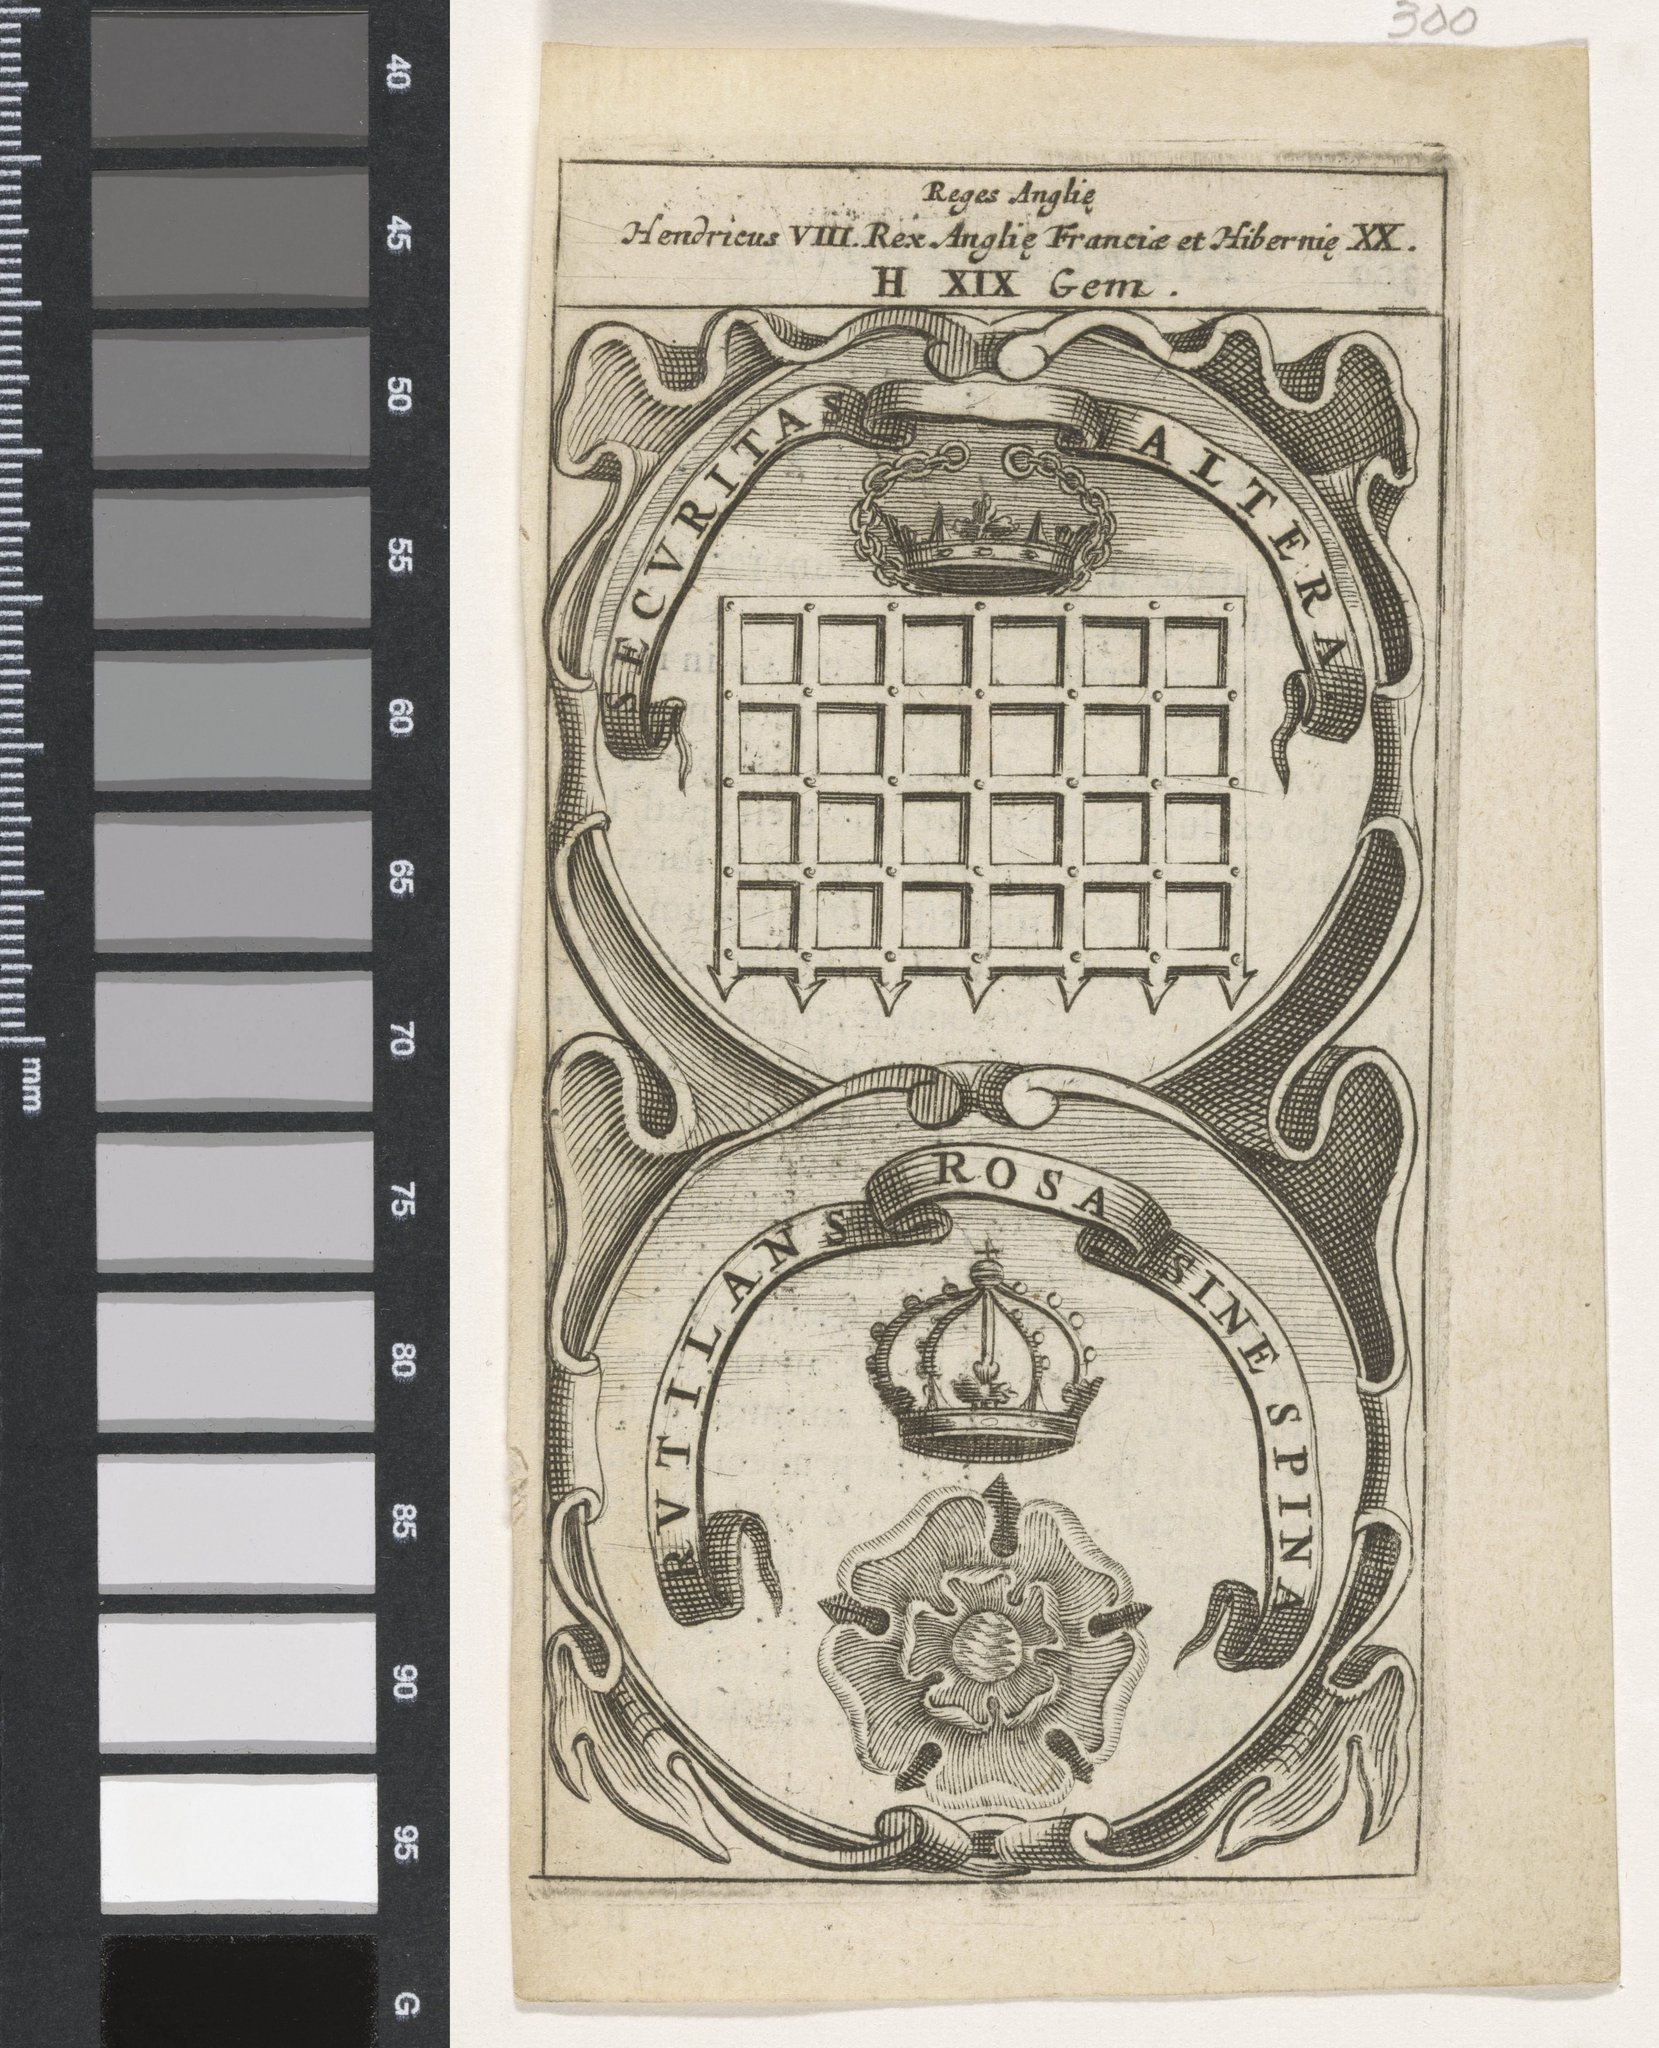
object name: print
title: Symbola Divina et Humana Pontificum Imperatorum Regum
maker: Anonymous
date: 1666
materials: paper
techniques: engraving, letterpress printing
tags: crown (symbol of sovereignty), portcullis, flowers: rose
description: Pagina uit Jacob Typotius, Symbola Divina & Humana Pontificum Imperatorum Regum. Arnhem, J.F. Hagen, 1666 of uit de titeluitgave van 1669 of 1679. Het werk van Typotius werd voor het eerst uitgegeven in 1601 met prenten van Aegidius Sadeler.